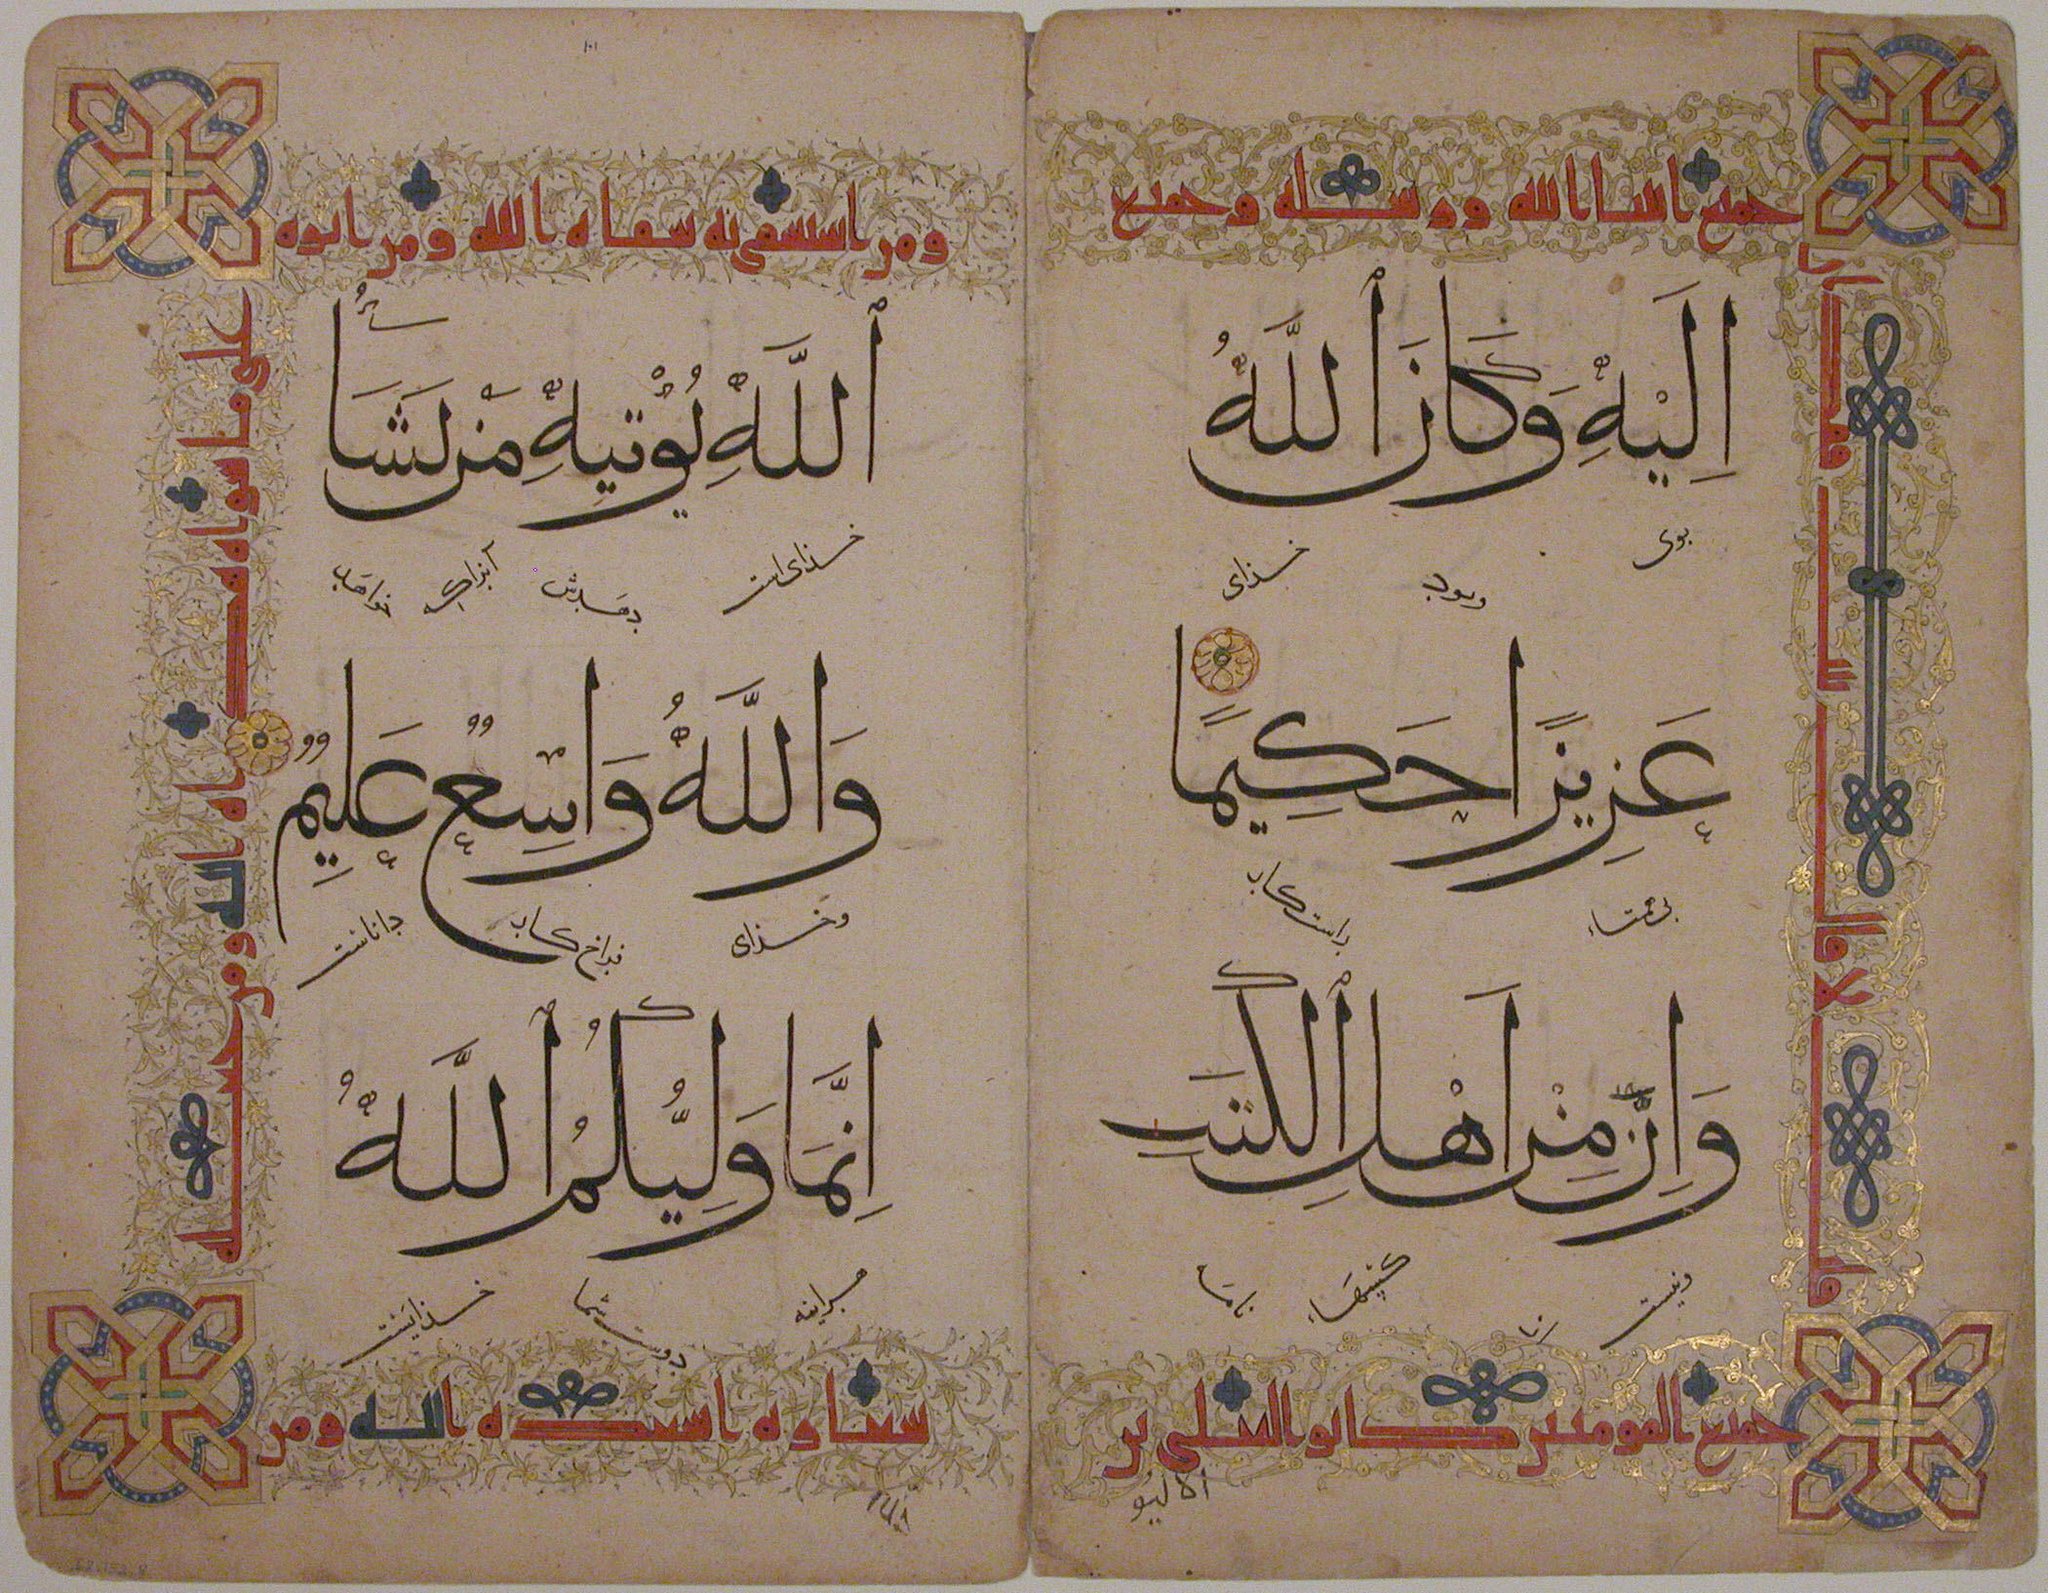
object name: bifolio from a non illustrated manuscript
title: Bifolium from a Qur'an Manuscript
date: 1401-1500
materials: gold, ink, paper, watercolor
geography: india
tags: qur'an